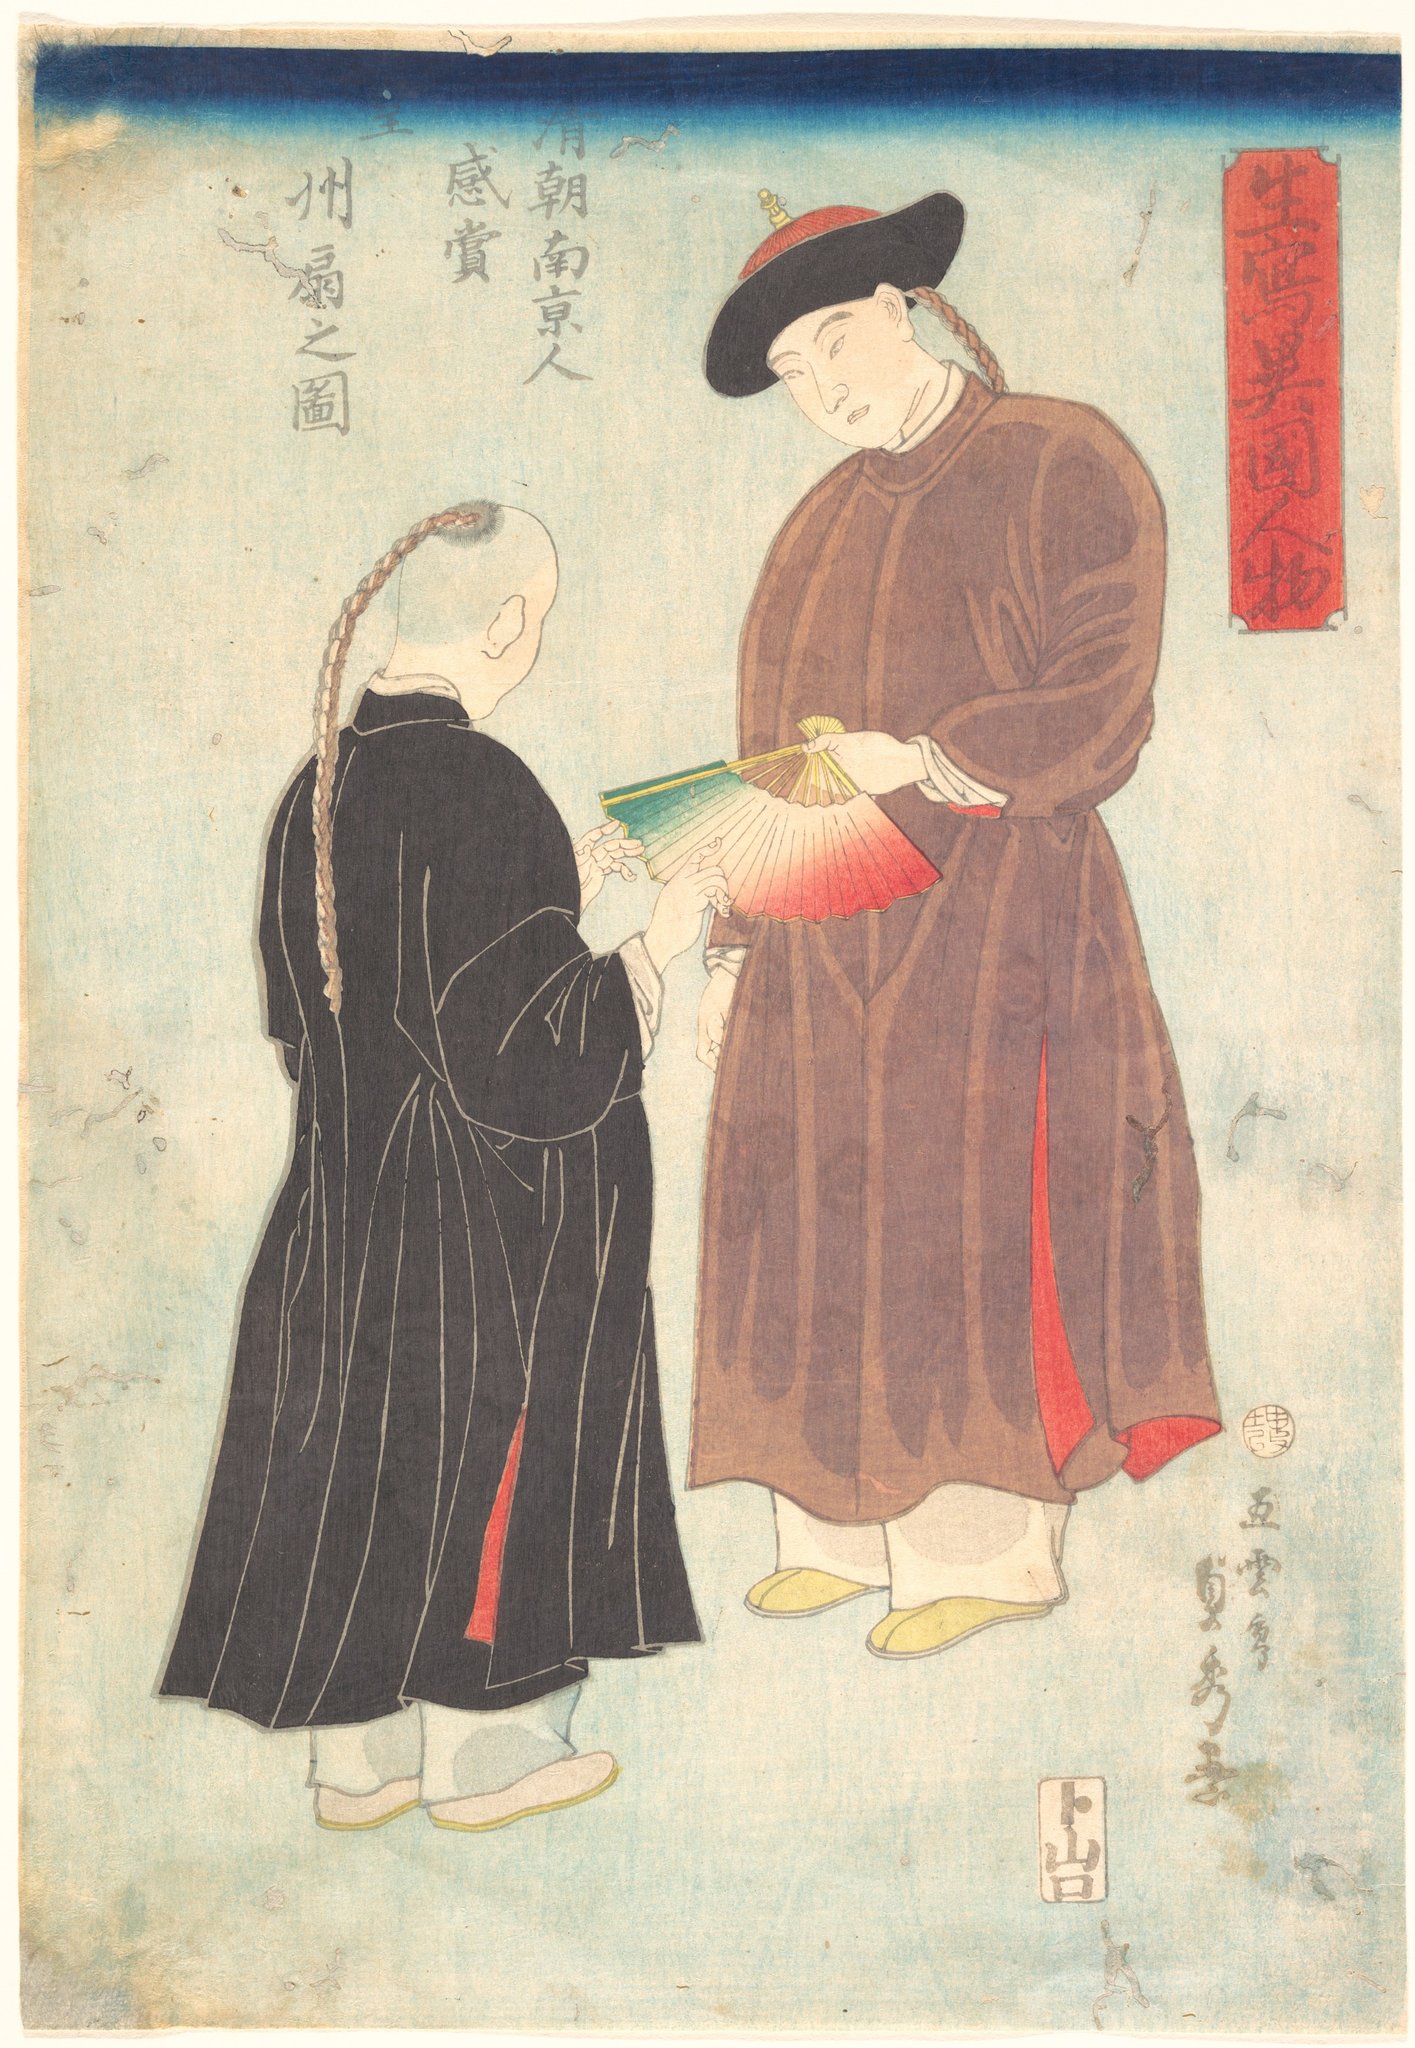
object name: print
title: Two Chinese Men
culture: japanese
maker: utagawa (gountei) sadahide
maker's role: artist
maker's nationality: japanese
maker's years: 1807-1873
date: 1807-1879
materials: ink, paper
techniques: woodblock print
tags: fans,men